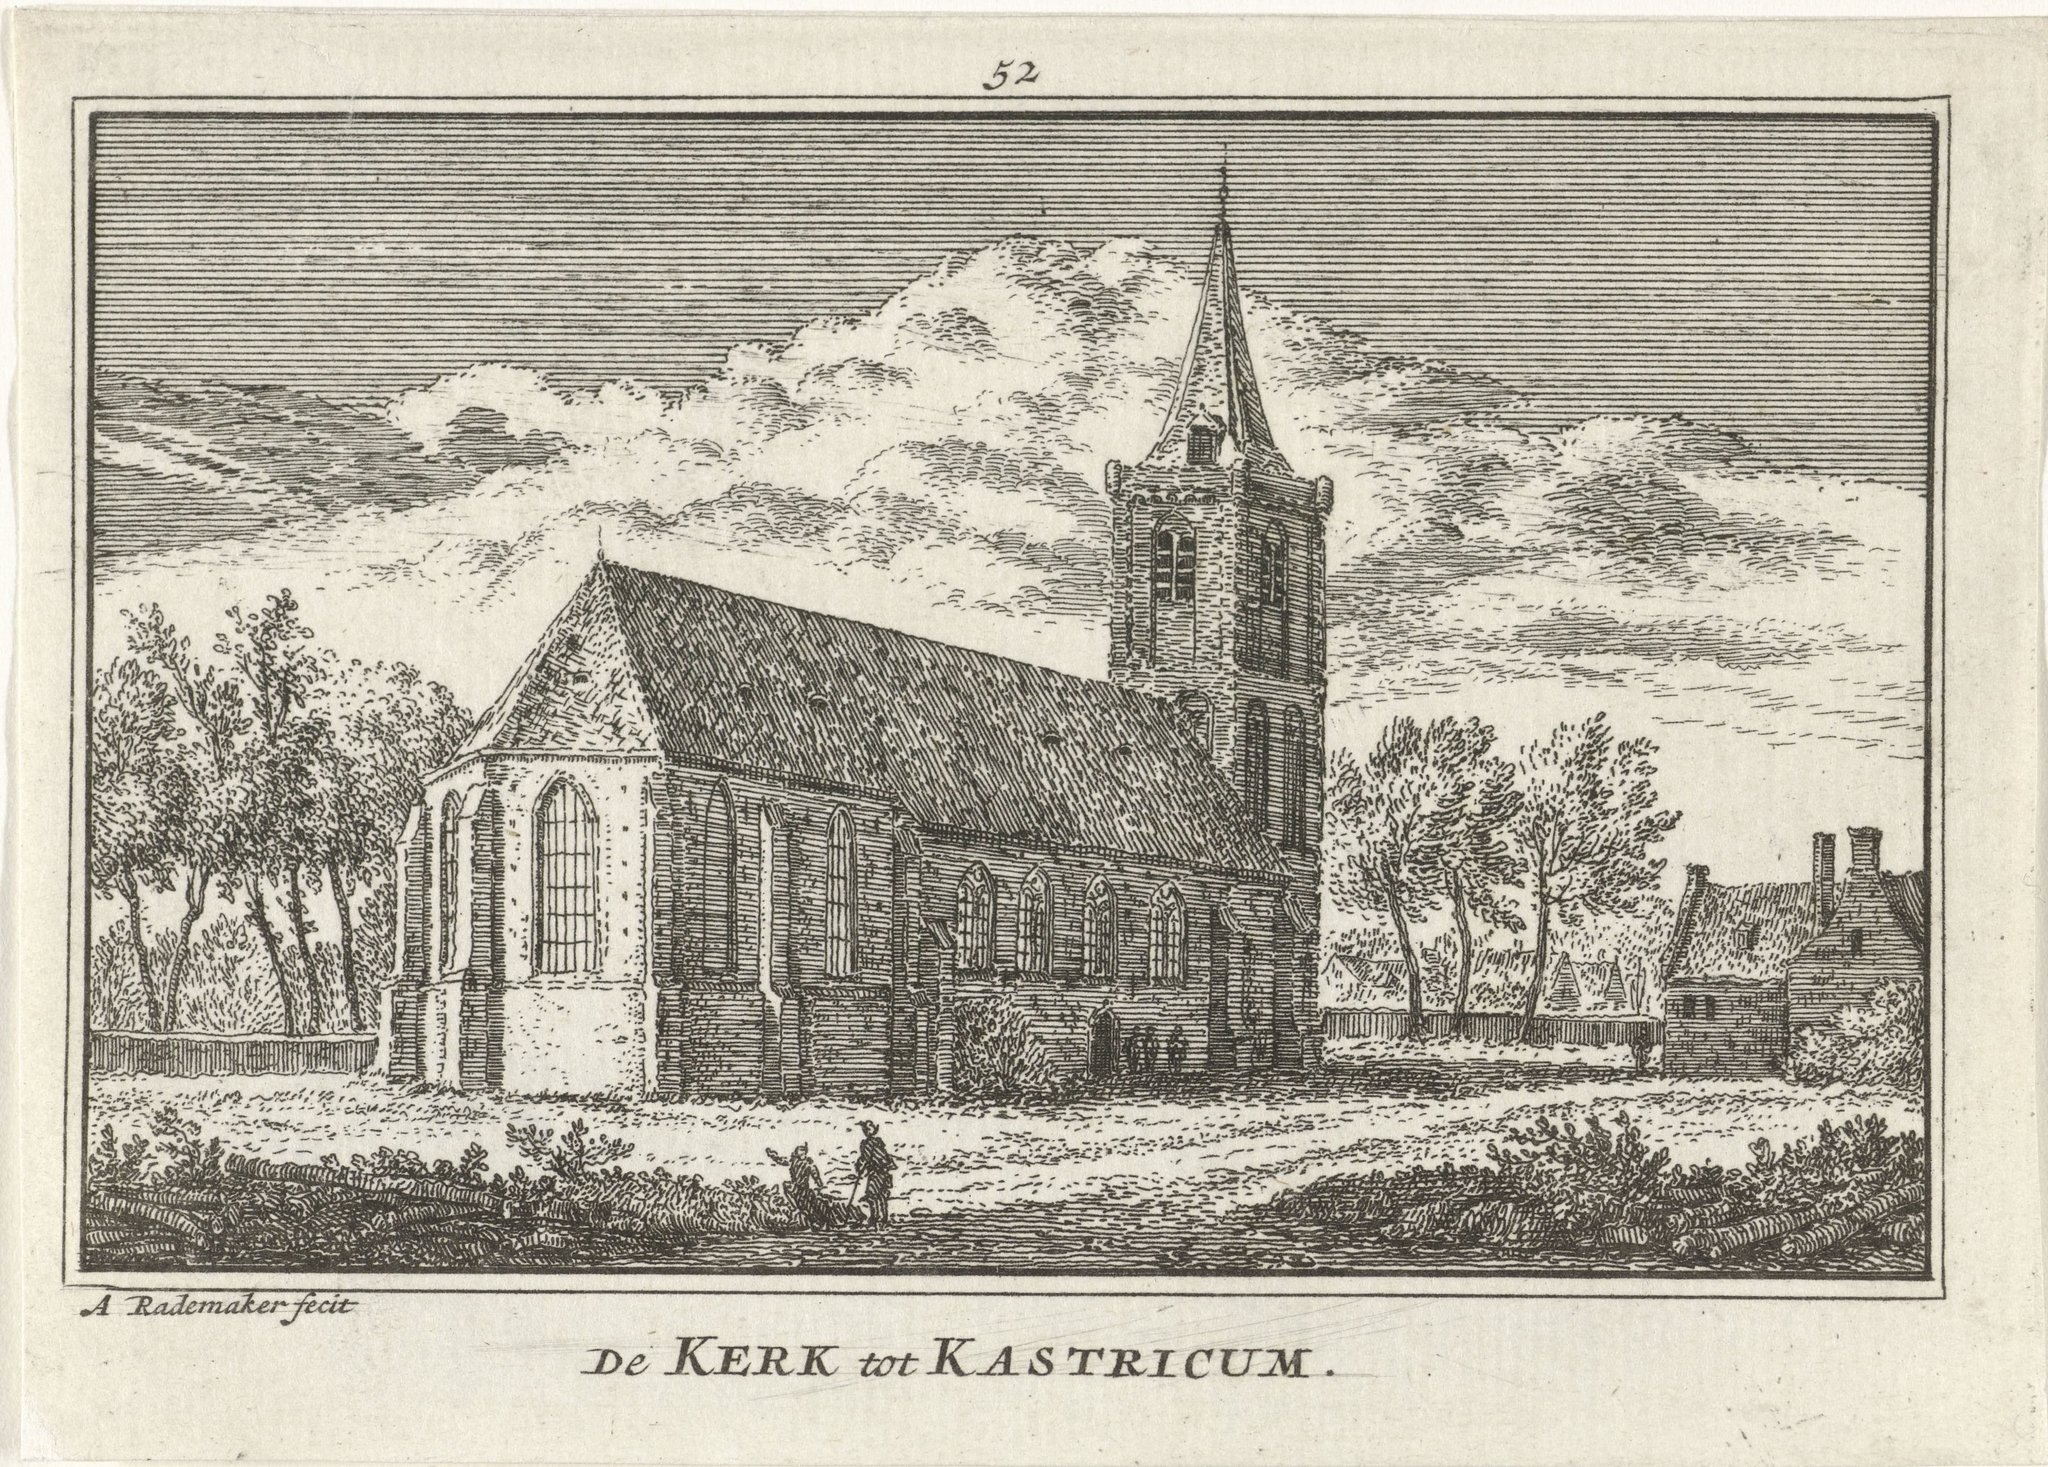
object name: book illustration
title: Gezicht op de Dorpskerk te Castricum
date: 1727-1733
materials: paper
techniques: etching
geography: amsterdam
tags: church (exterior)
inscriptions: collector's mark: Lugt 2228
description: Illustratie uit: Abraham Rademaker, Matthaeus Brouërius van Niedek, Isaac Le Long, Kabinet van Nederlandsche en Kleefsche outheden en (...) voorname stads- en landgebouwen, Willem Barents en Antoni Schoonenburg: Amsterdam, 1727-1733, ill. nr. 52.